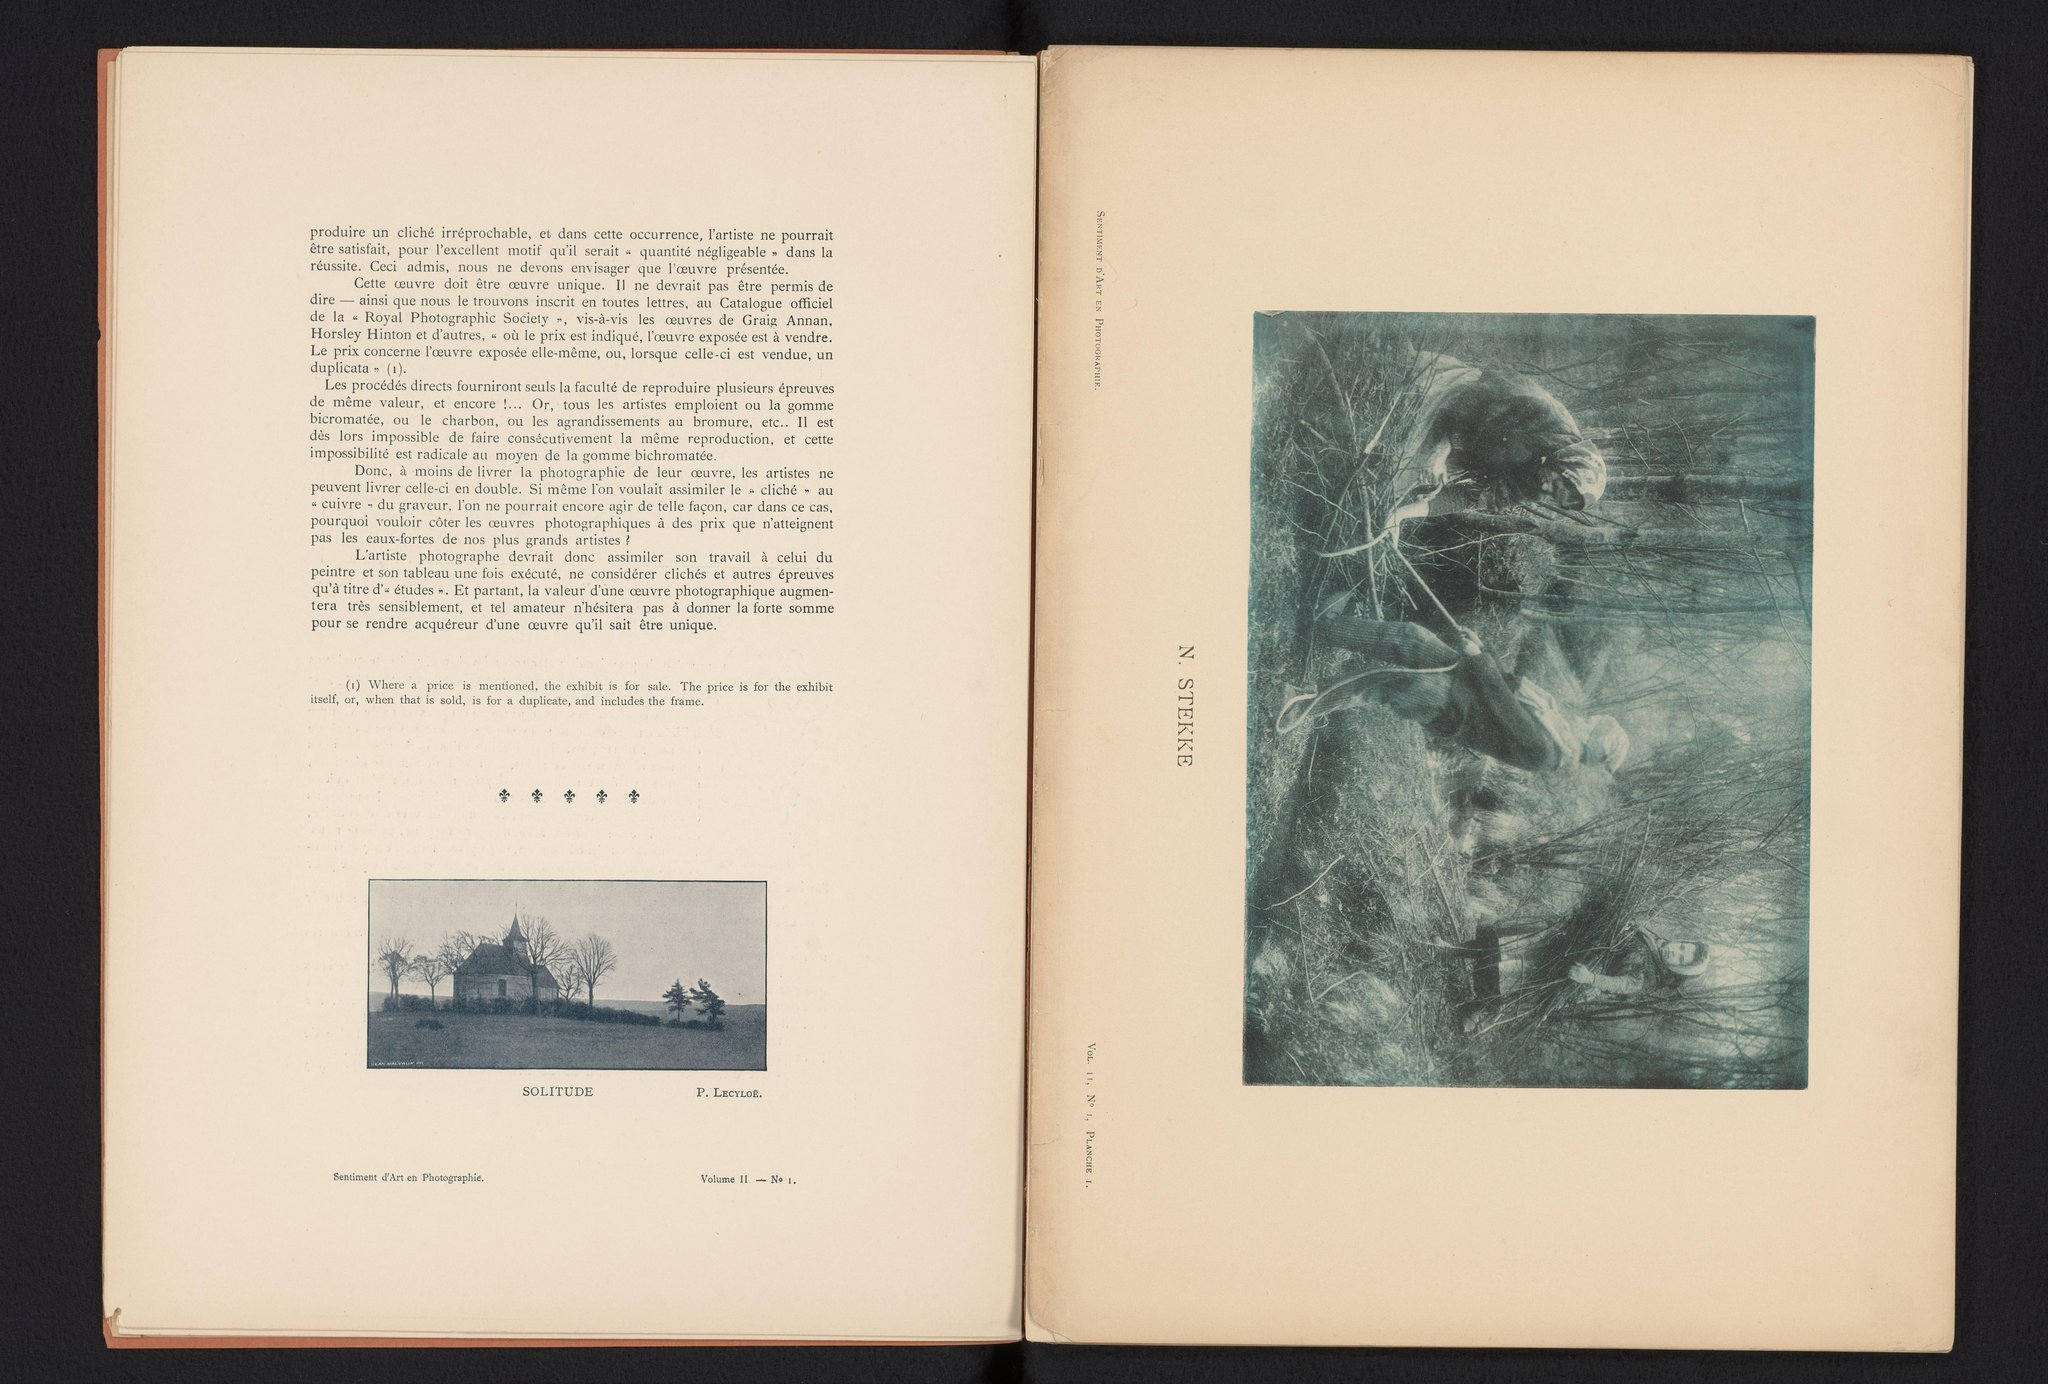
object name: photomechanical print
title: Sentiment d'Art en Photographie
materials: paper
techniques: photograph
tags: forest, wood, mother and child(ren), woman and child(ren) (family group)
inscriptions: number: ‘Vol. II, No 1, Planche 1.’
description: Deze prent maakt deel uit van 8 omslagen met 22 tekstbladen en 89 prenten op losse bladen in en tussen de omslagen.